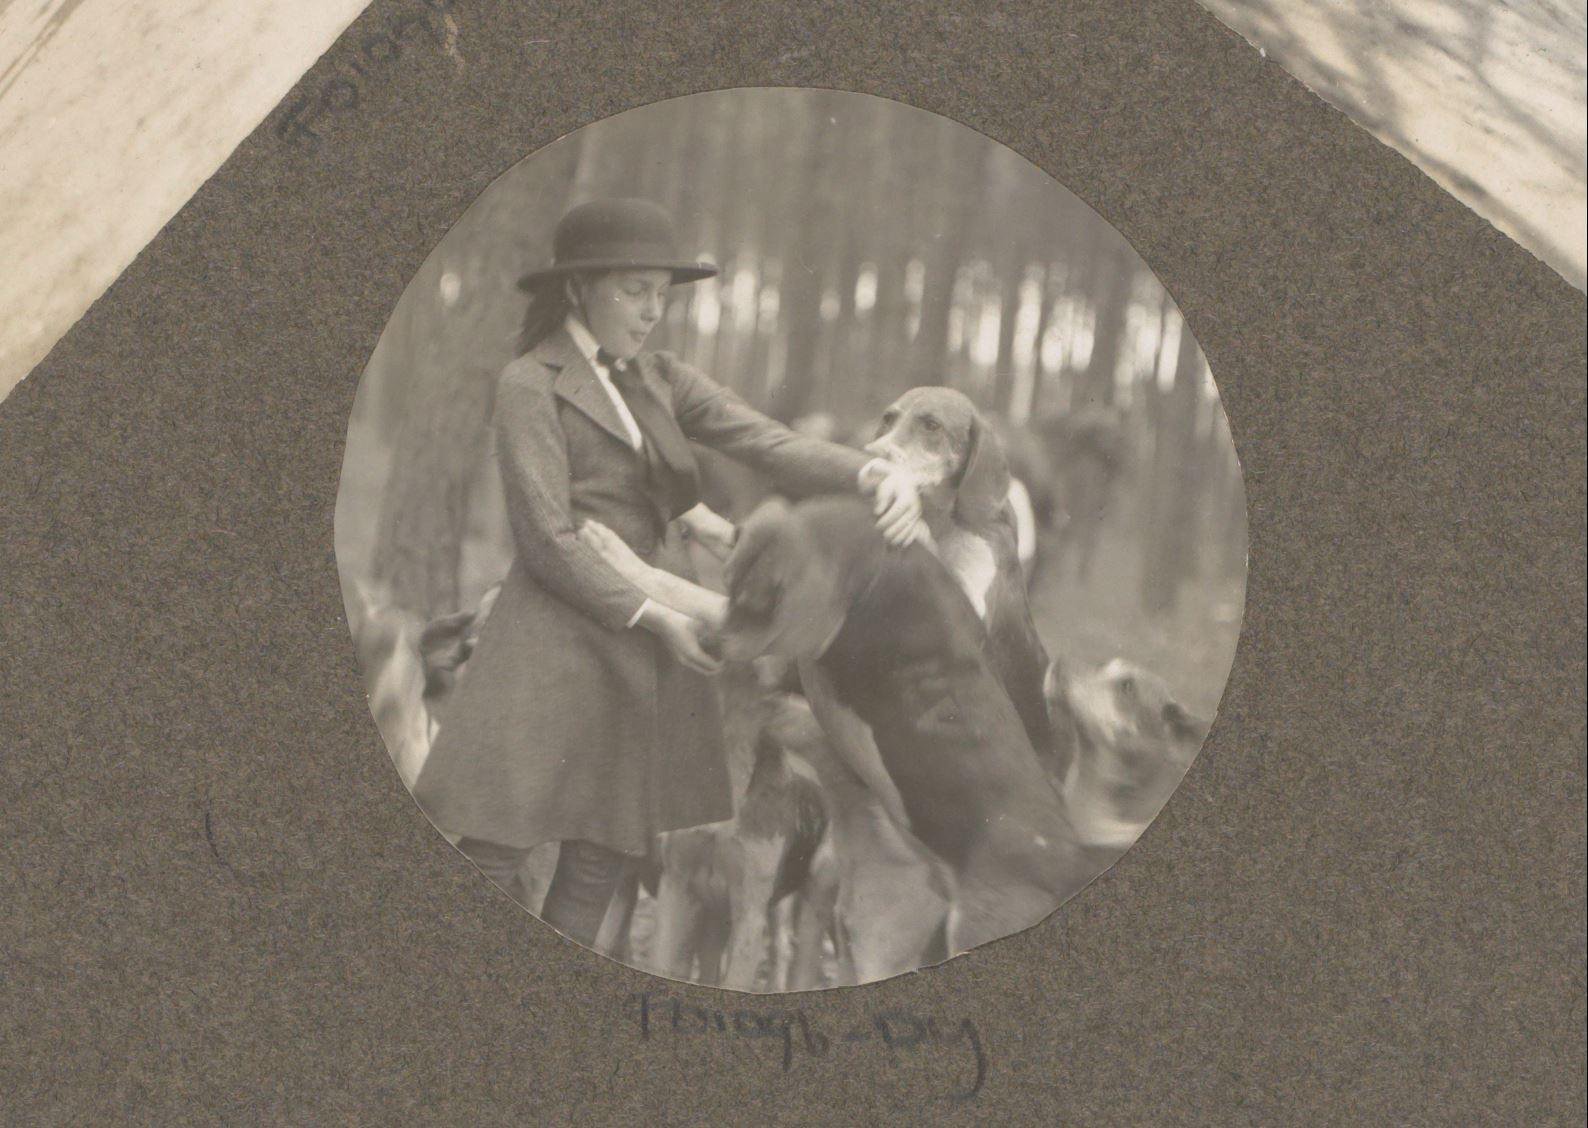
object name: photograph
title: Ruitertafereel op Koninklijke Houtvesterij Het Loo: meisje speelt met jachthonden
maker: Anonymous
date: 1900-1925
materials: photographic support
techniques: gelatin silver print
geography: het loo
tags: adolescent, young woman, maiden, hunting dogs, hunting-ground, child playing with animals, dog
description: Onderdeel van Fotoalbum van de heer Brams, opperhoutvester van koningin Wilhelmina op Koninklijke Houtvesterij Het Loo.